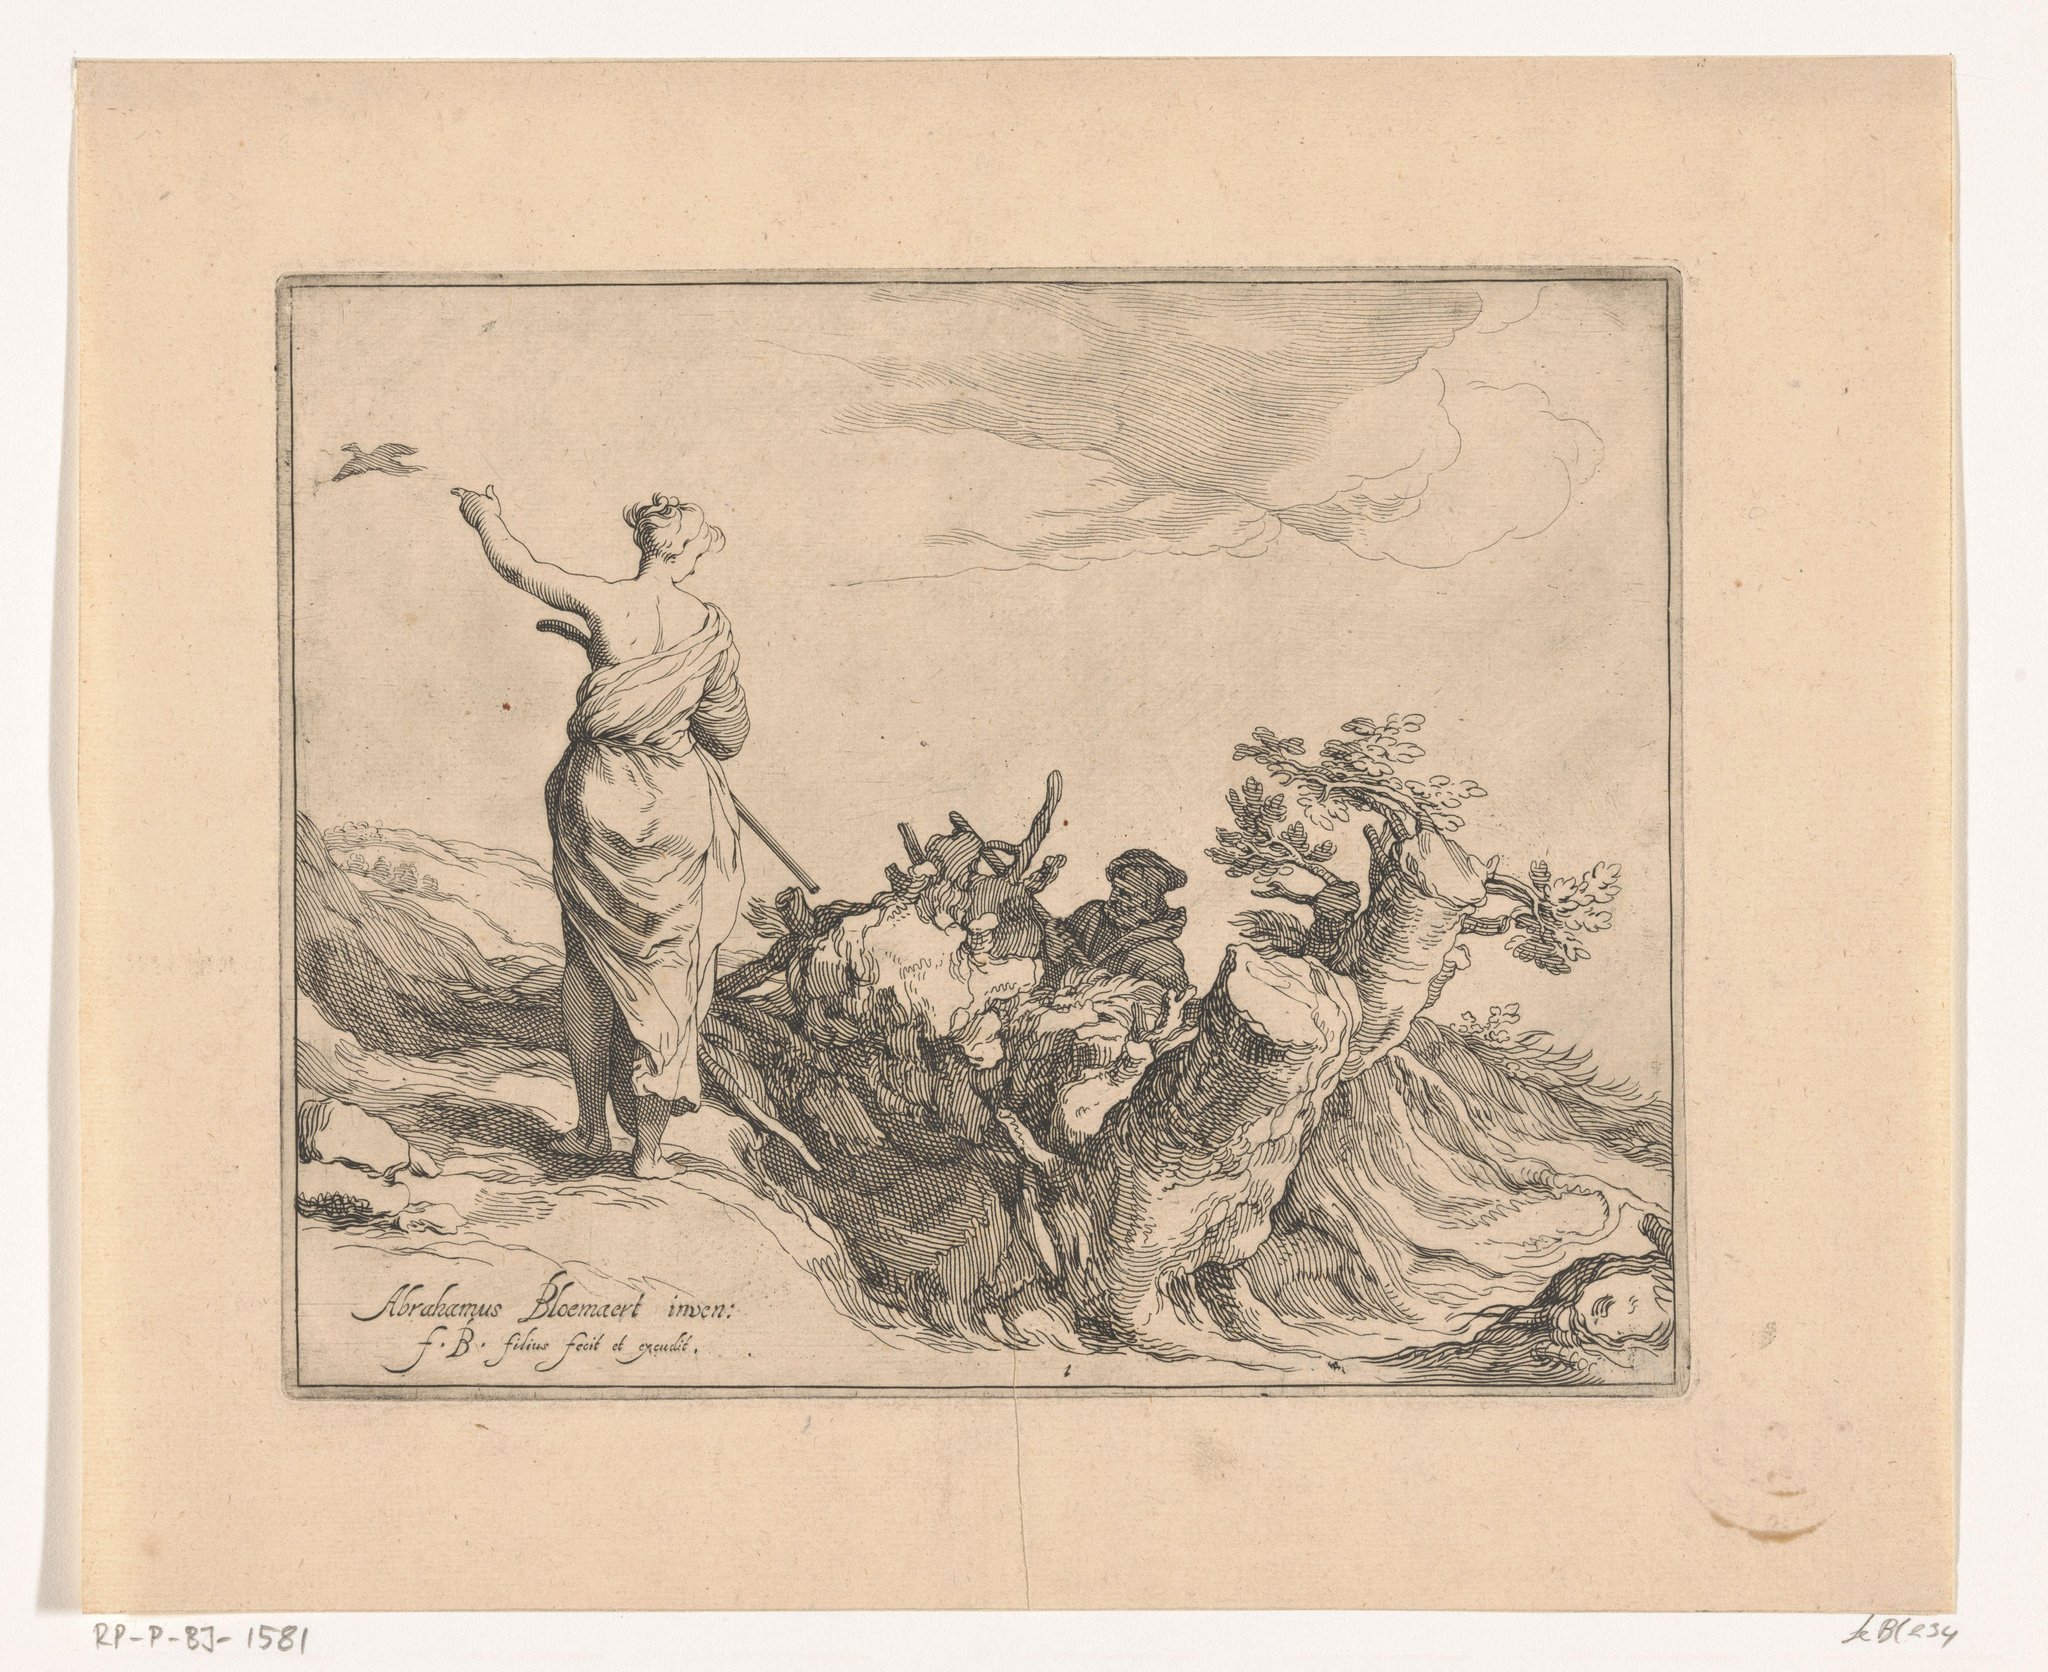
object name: print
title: Grote landschappen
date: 1635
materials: paper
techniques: etching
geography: utrecht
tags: landscapes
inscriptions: collector's mark: Lugt 240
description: Tussen boomstronken zit een jager met geweer. Links een vrouw, op de rug gezien, ze wijst met haar linkerhand naar een vogel in de lucht.